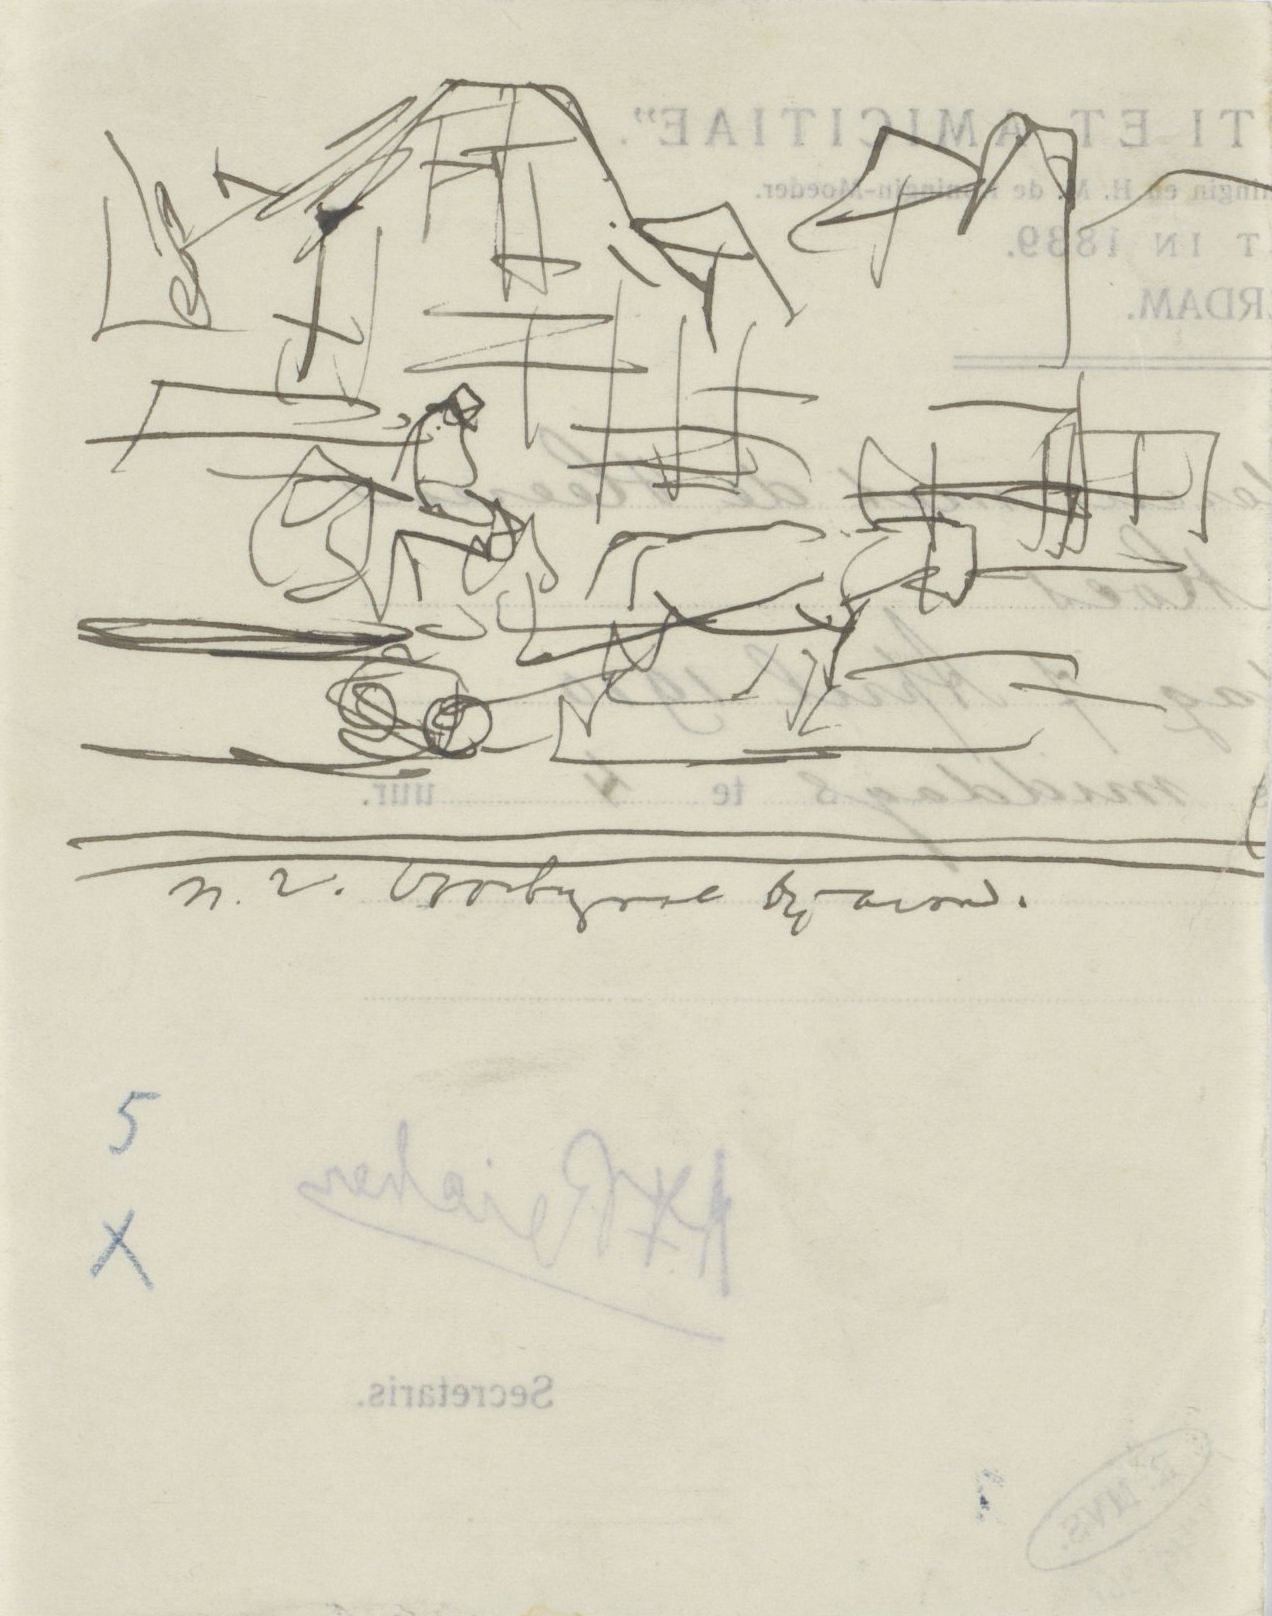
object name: letter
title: Gezicht op de Nieuwezijds Voorburgwal te Amsterdam bij avond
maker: george hendrik breitner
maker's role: draughtsman, painter, print maker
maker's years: 1857-1923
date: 1910-1923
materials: ink, paper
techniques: pen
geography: amsterdam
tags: four-wheeled vehicle drawn by one animal, street (+ city(-scape) with figures, staffage)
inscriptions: collector's mark: Lugt 2228, annotation: ‘[Briefhoofd Arti et Amicitiae]/ met de Heeren/ Hoes/ dag 7 April 1910/ 's middags te 4 uur./ A.F. Reicher/ Secretaris.’, annotation: ‘N.Z. Voorburgwal bij avond.’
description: Vooraan een paard-en-wagen. Verso een brief van A.F. Reicher, secretaris van kunstenaarsvereniging Arti et Amicitiae.